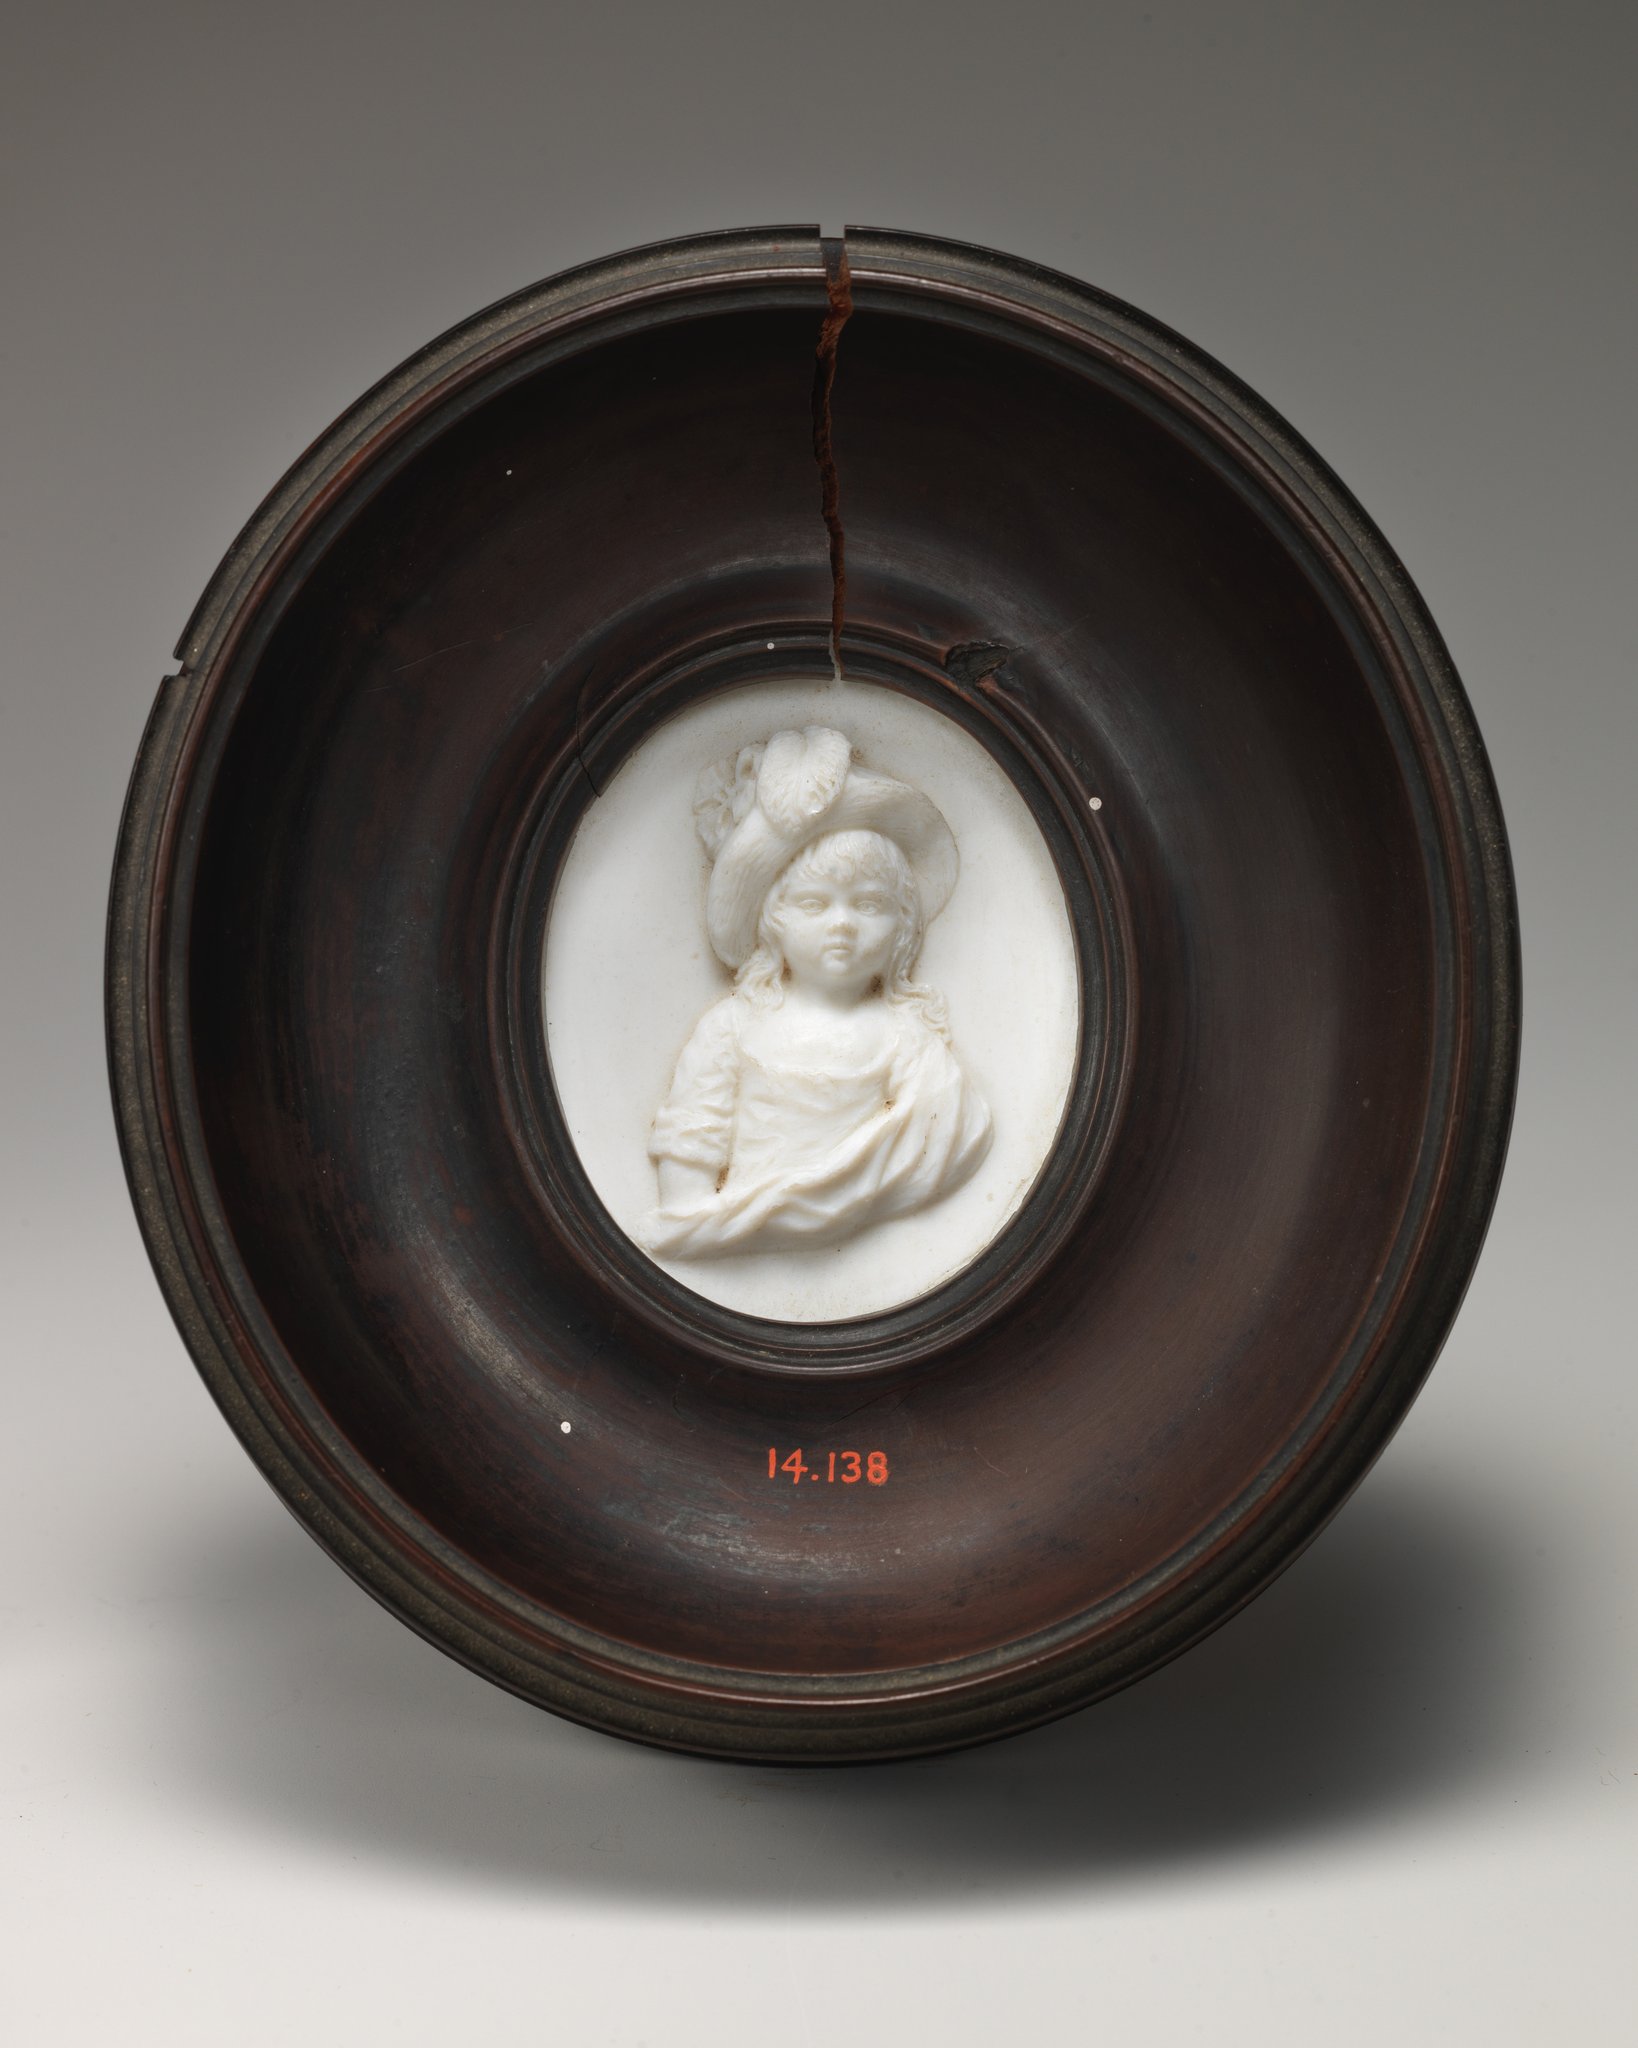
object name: medallion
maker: james tassie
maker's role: artist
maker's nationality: british, scottish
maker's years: 1735-1799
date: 1701-1800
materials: glass, paste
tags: girls,portraits